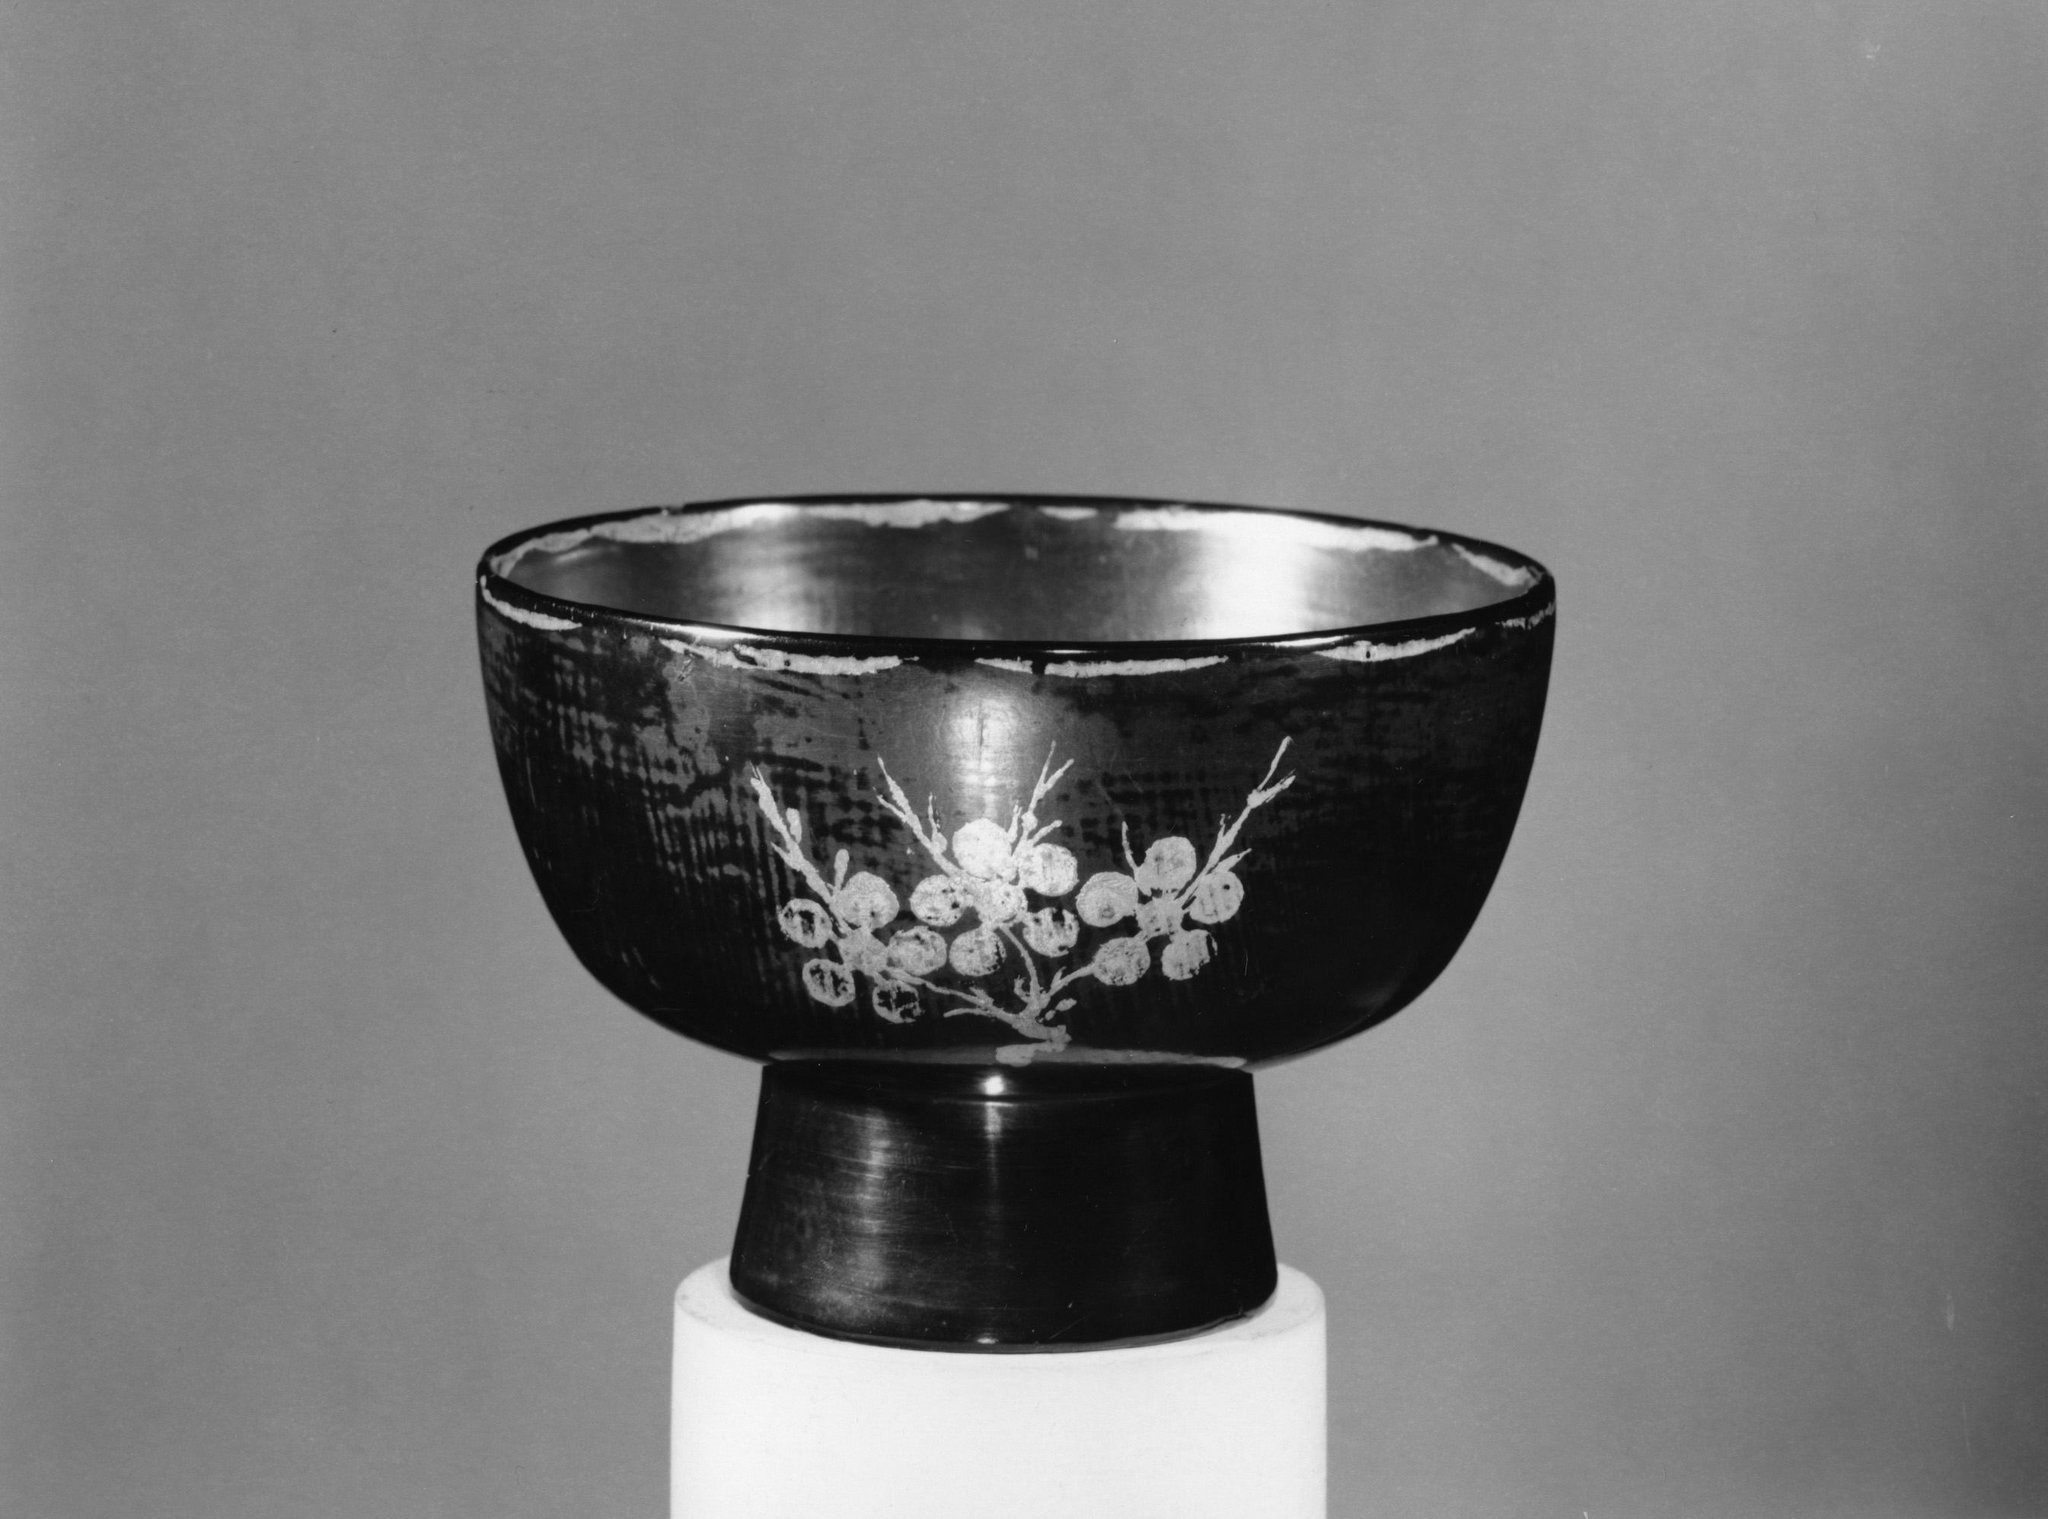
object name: bowl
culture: japanese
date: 1701-1800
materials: gold, lacquer, wood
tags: flowers